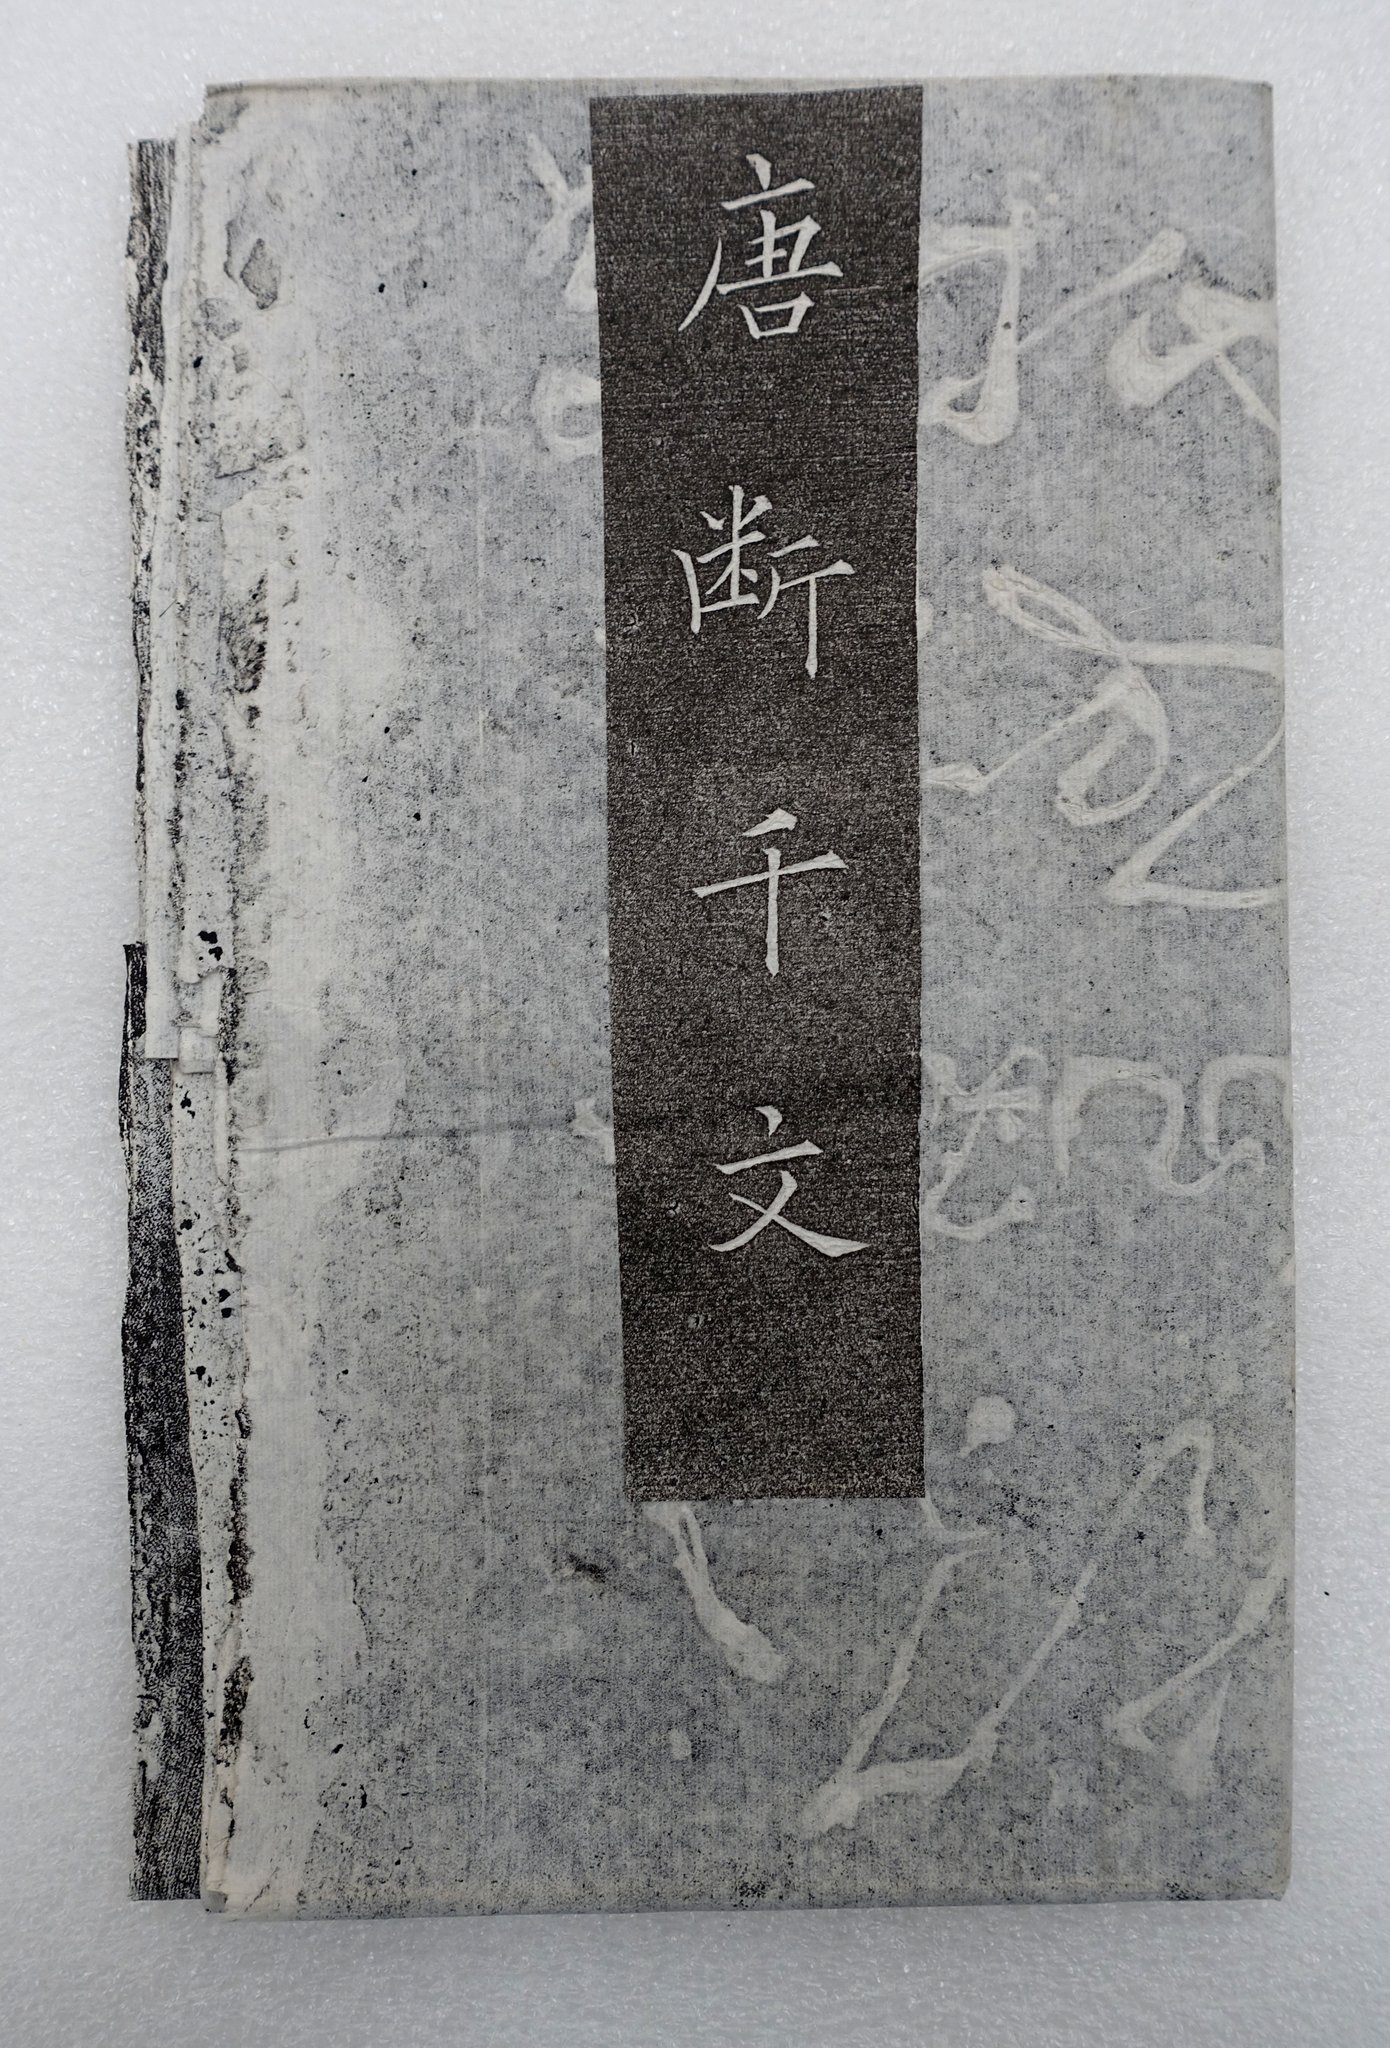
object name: rubbing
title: Fragmentary 1000-character essay written in cursive script in the Tang dynasty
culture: chinese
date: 1901-2000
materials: ink, paper